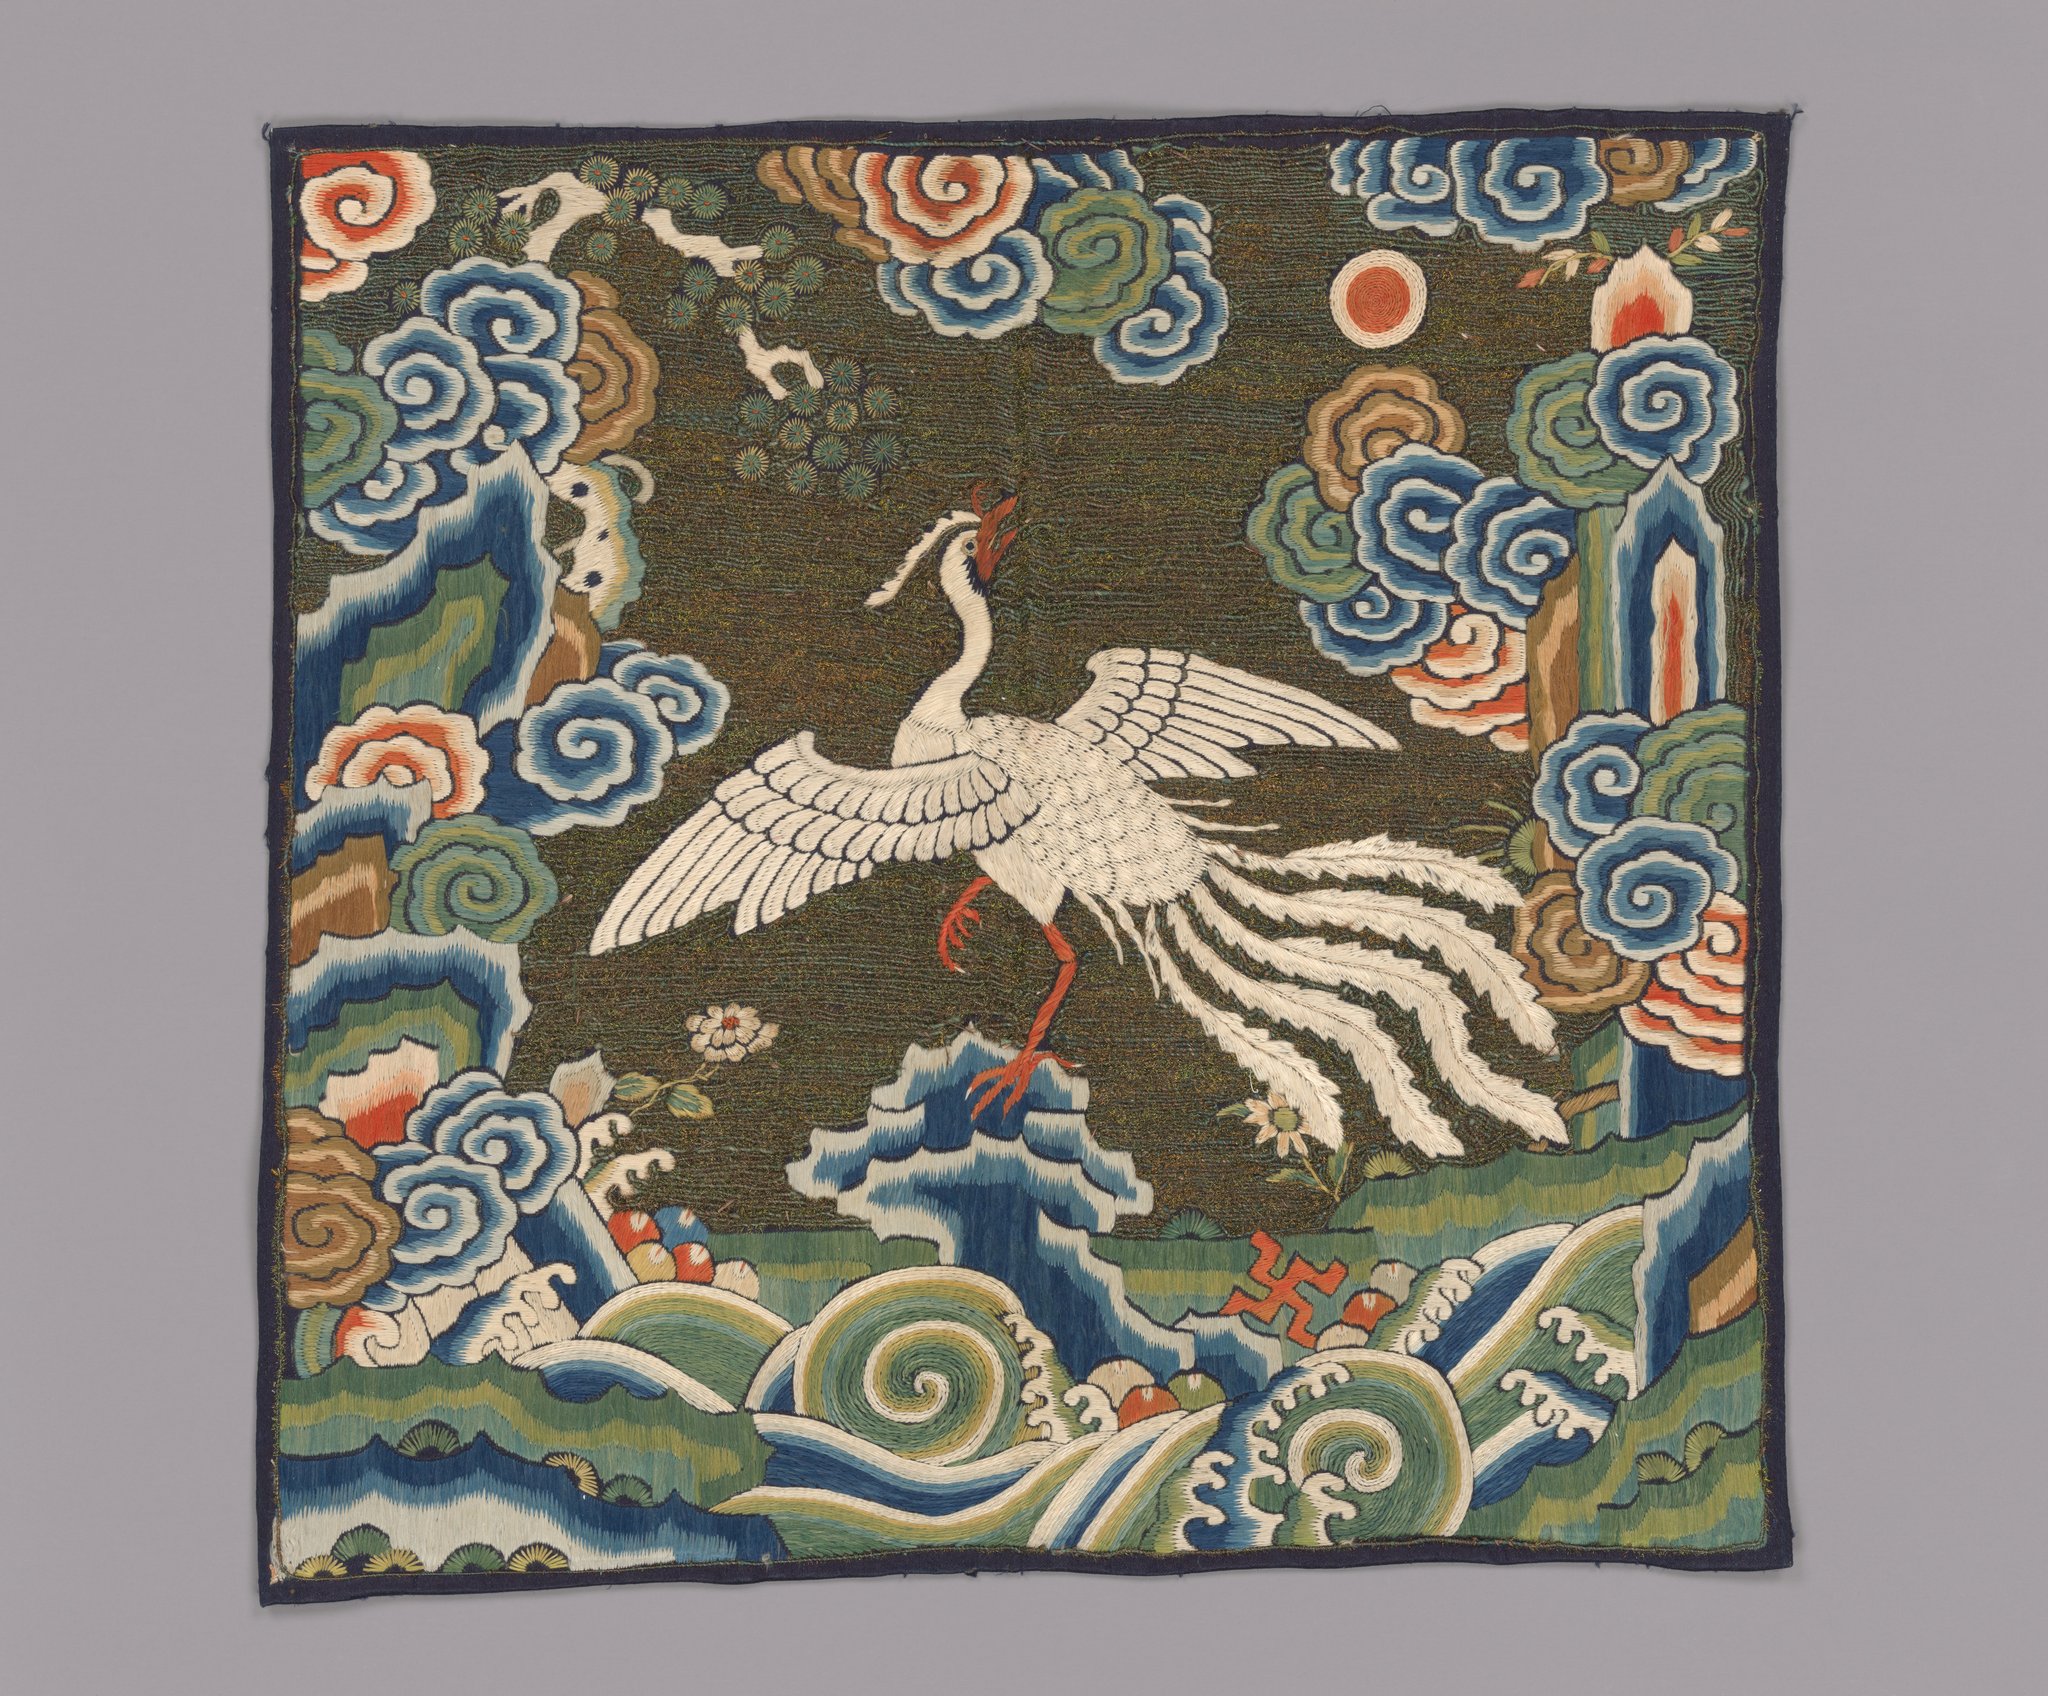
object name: rank badge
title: Rank Badge with Silver Pheasant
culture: chinese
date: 1701-1800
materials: silk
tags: pheasants